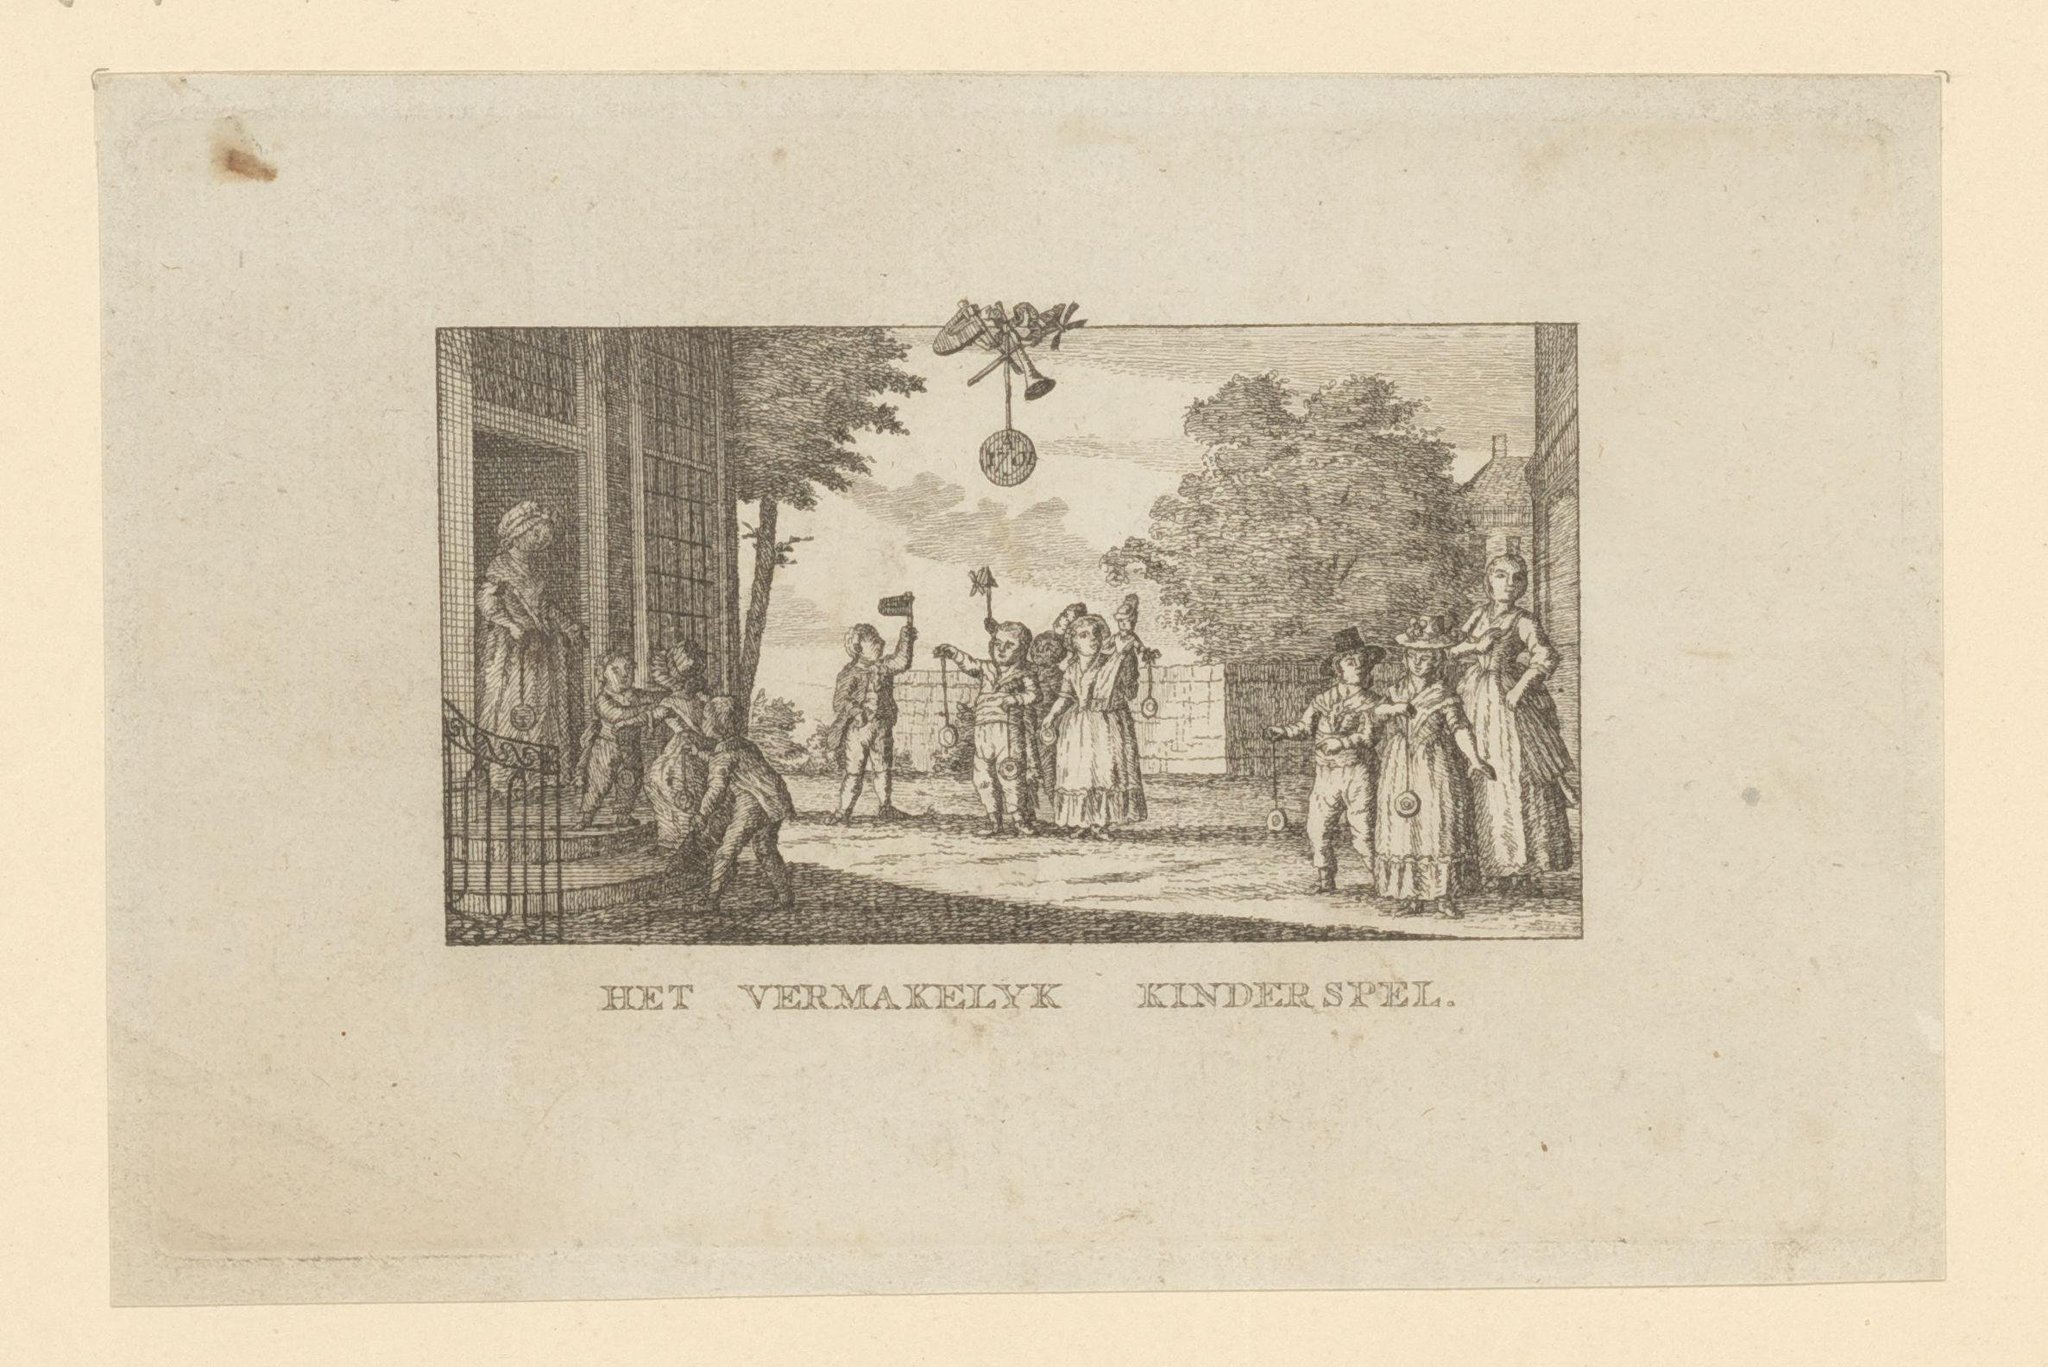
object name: print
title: Het vermakelyk kinderspel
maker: Anonymous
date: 1790-1795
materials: paper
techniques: engraving, etching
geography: netherlands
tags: yoyo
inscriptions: collector's mark, collector's mark: Lugt 1641